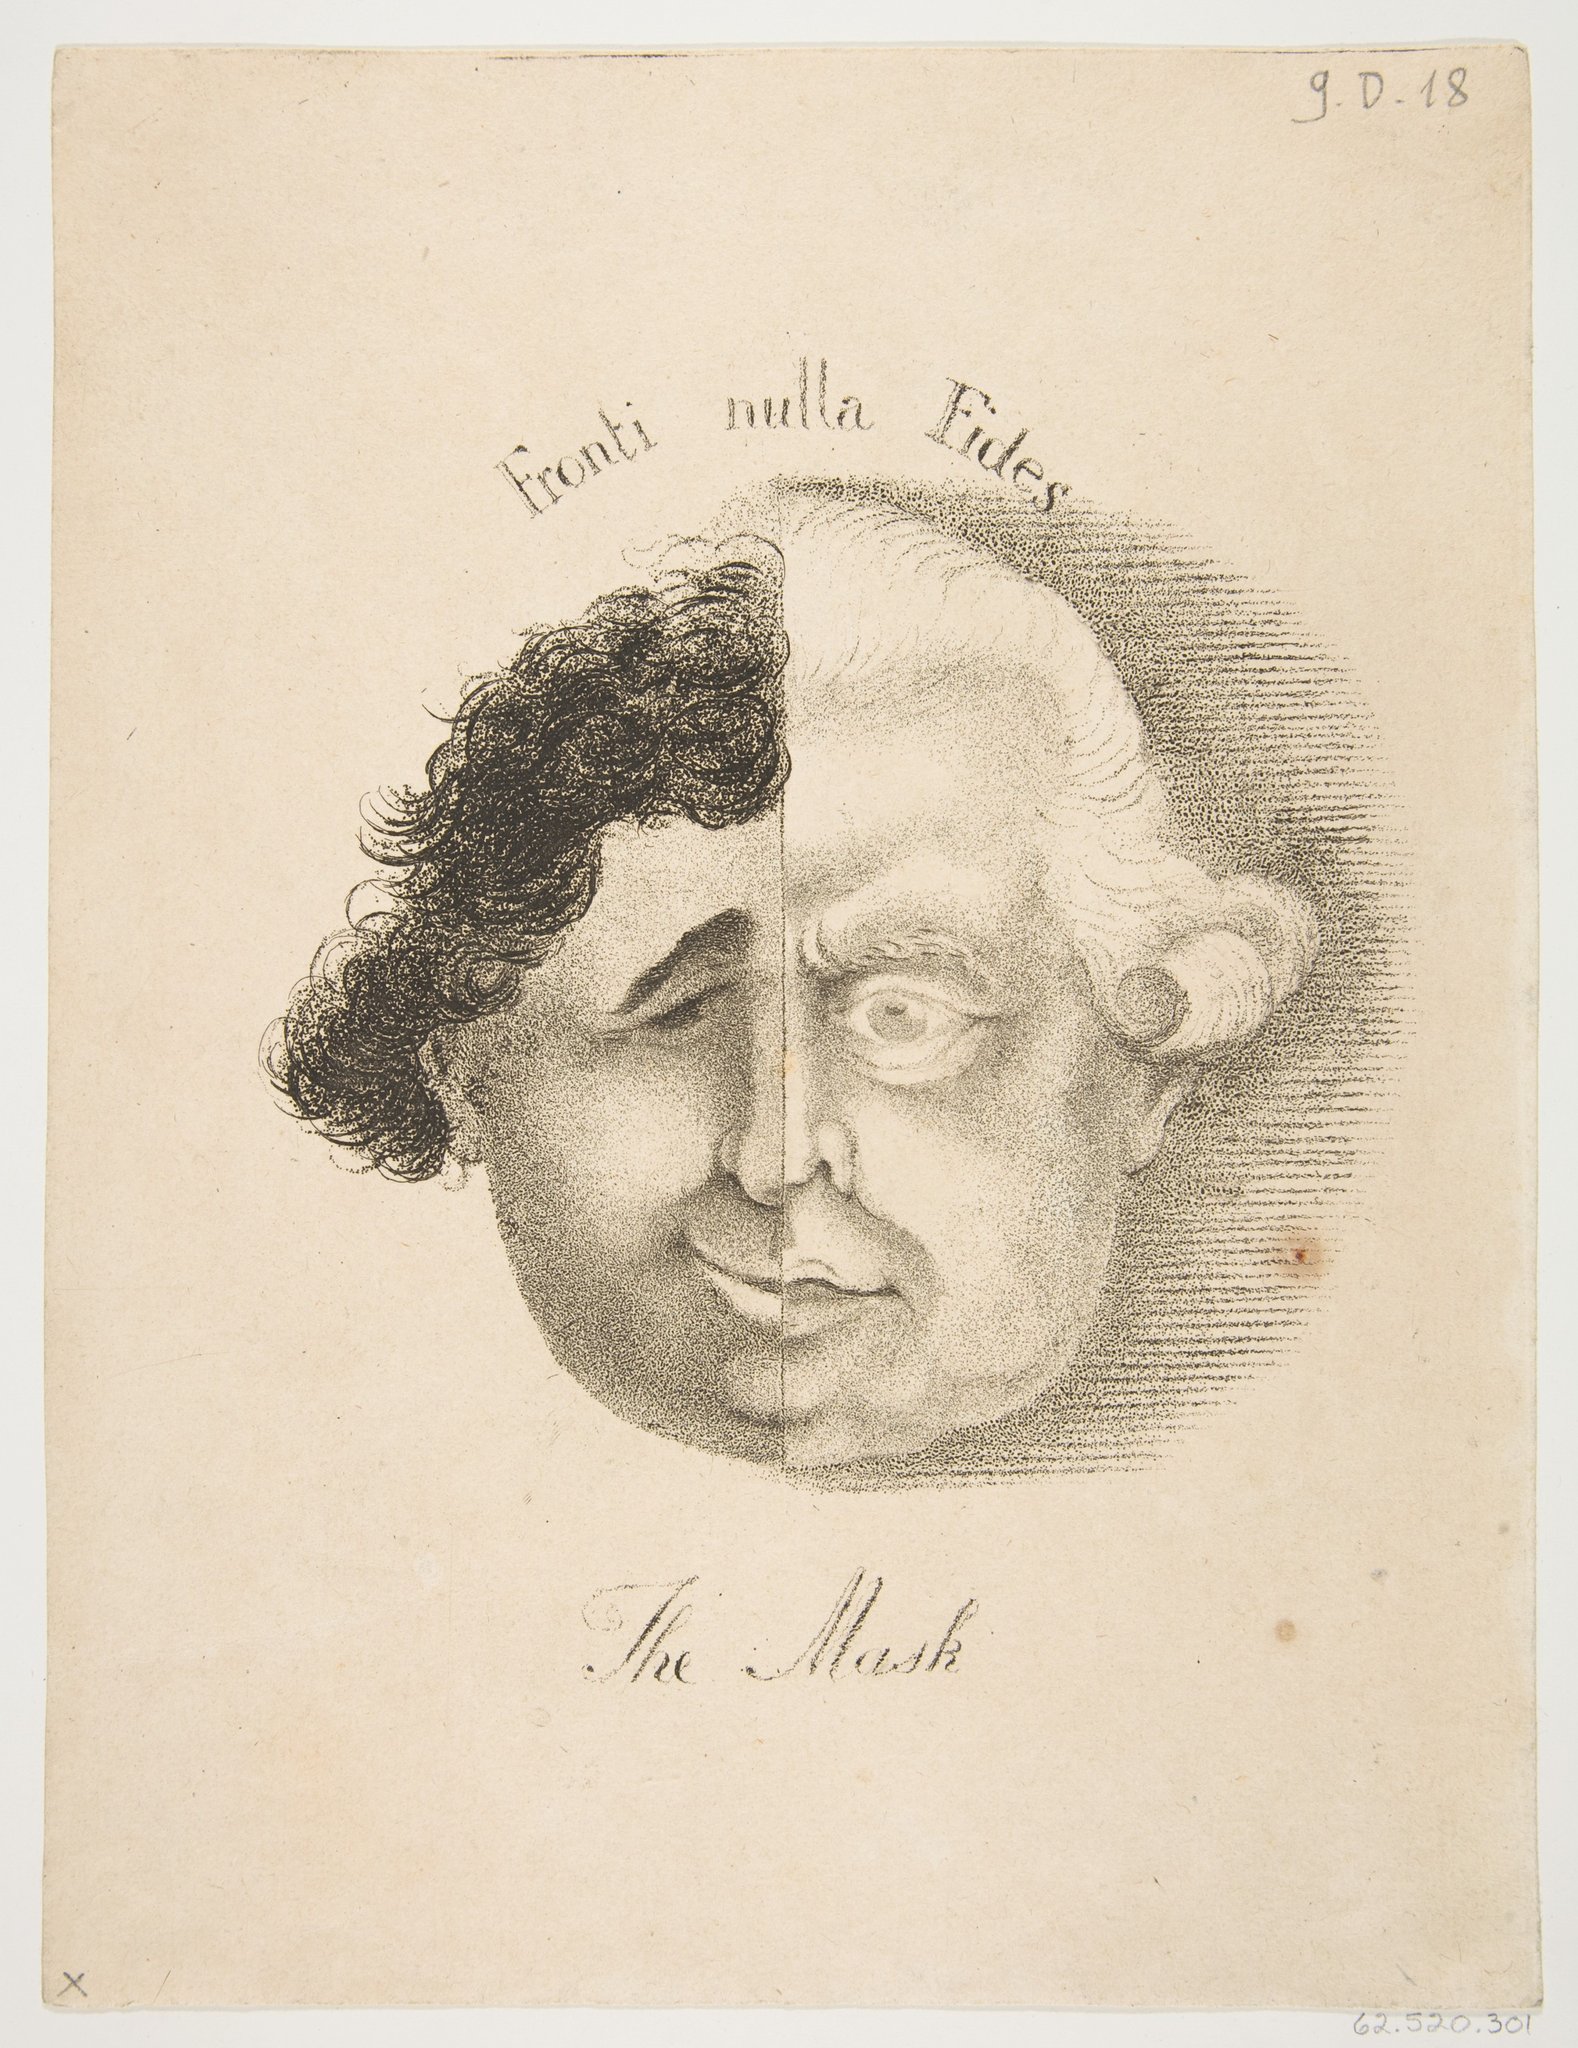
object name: print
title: The Mask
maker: james sayers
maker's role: artist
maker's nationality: british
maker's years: 1748-1823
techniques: engraving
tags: caricature,politics